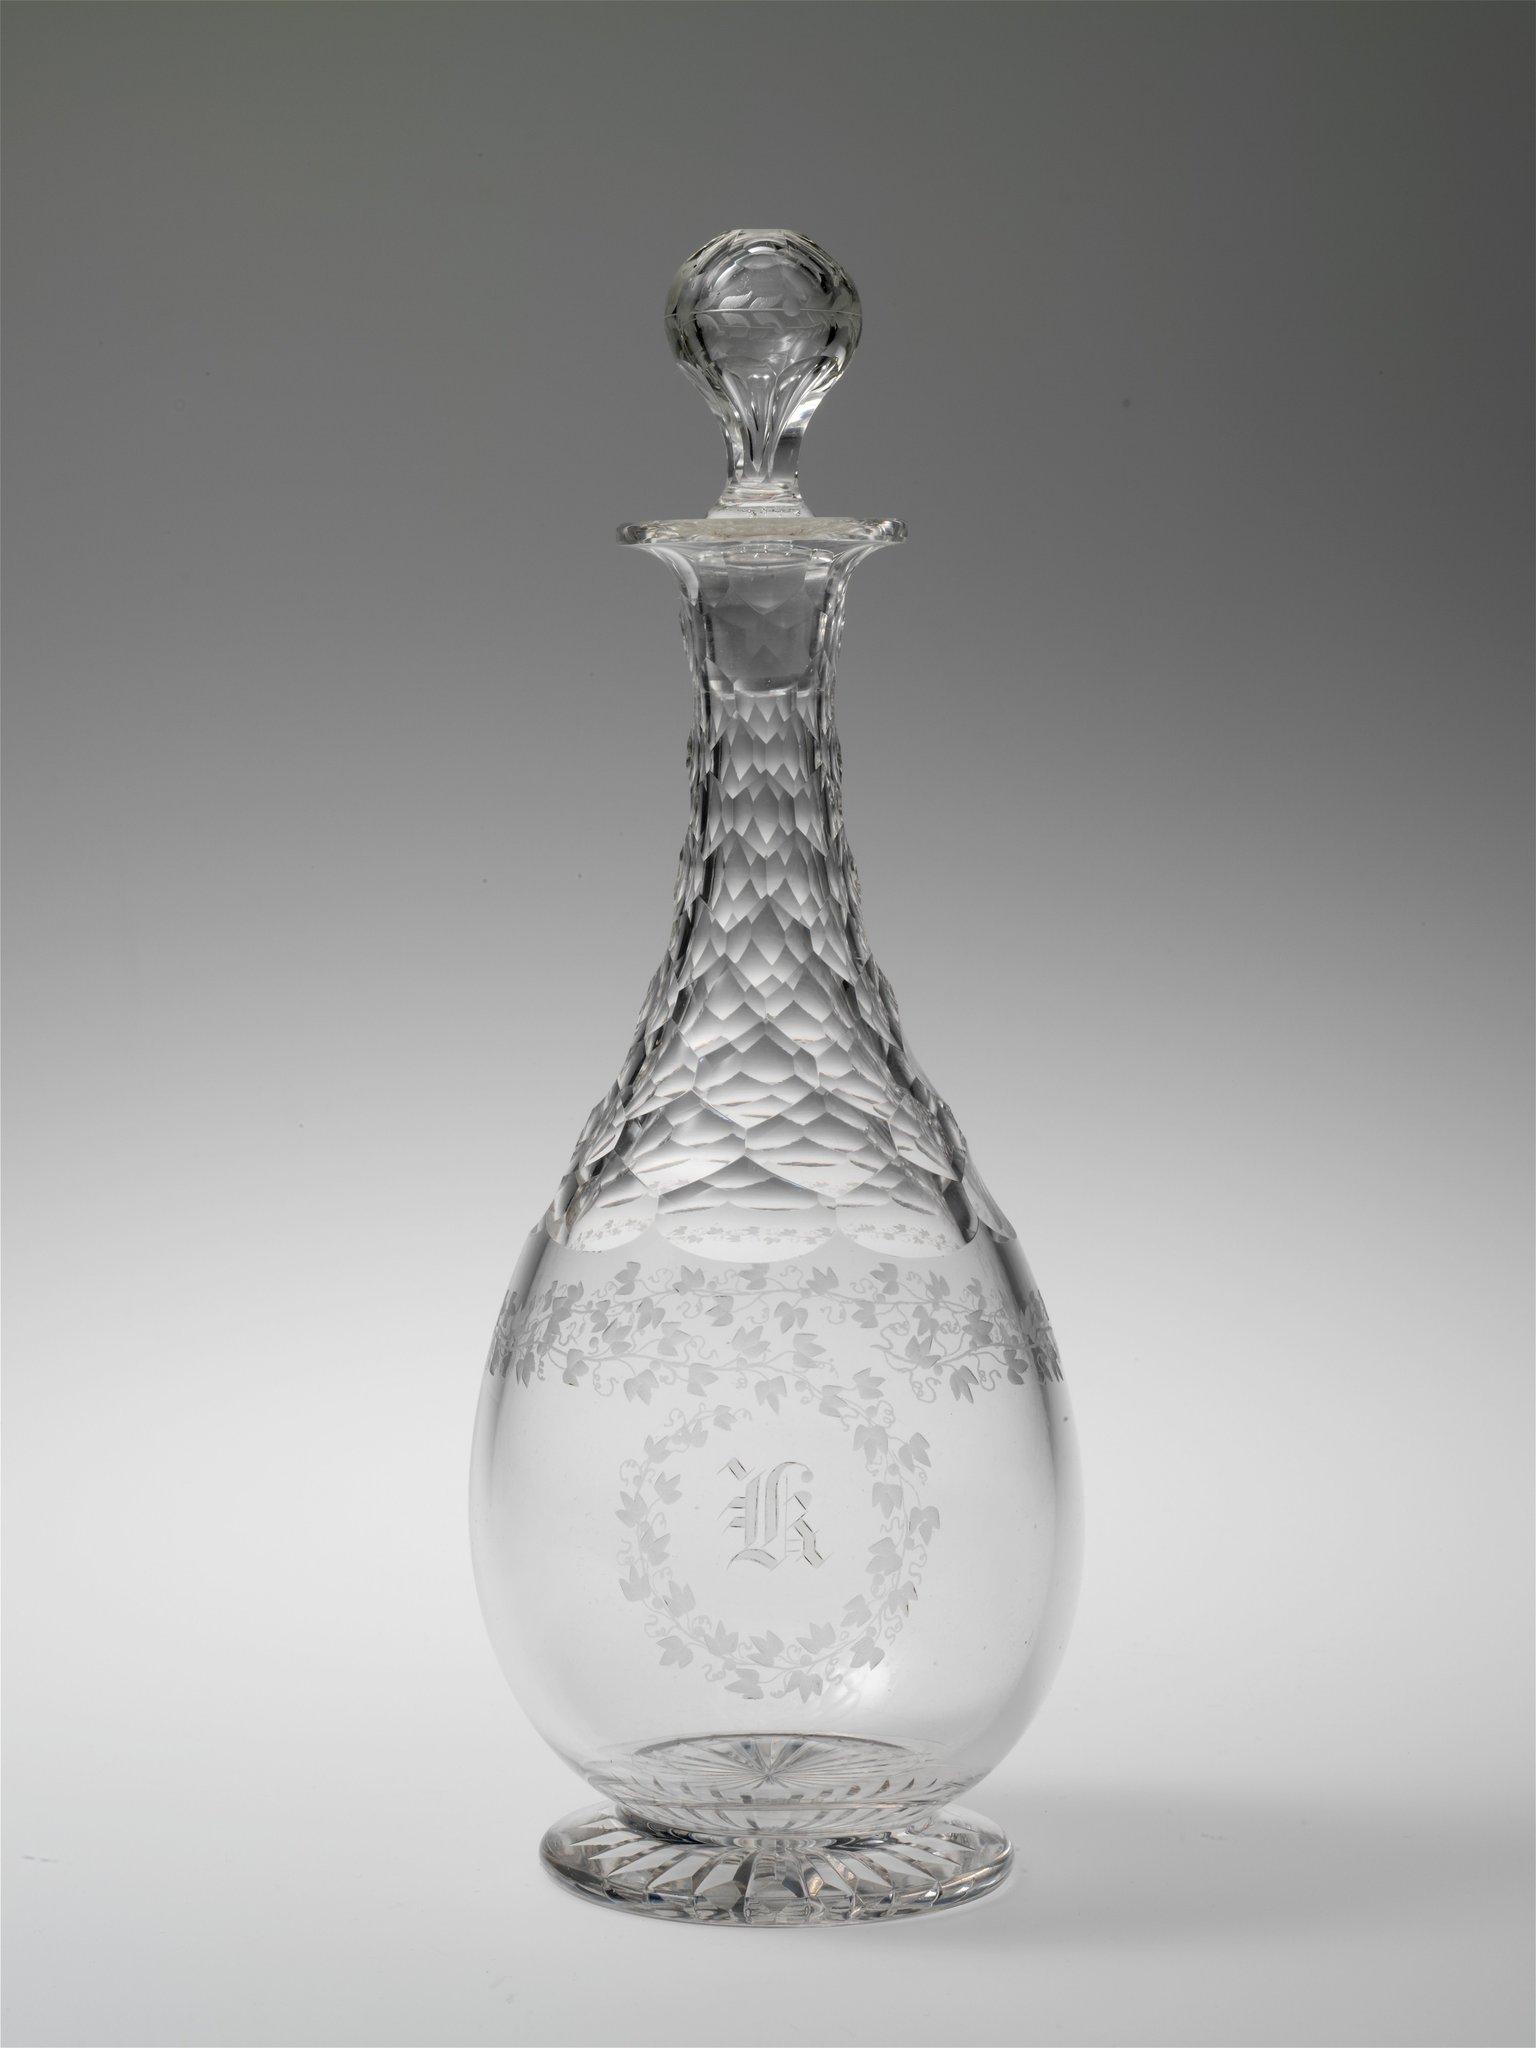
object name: decanter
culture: american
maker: boston & sandwich glass company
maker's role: manufacturer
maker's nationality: american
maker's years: 1825-1888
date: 1867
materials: glass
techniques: glassblowing, cutting, engraving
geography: united states